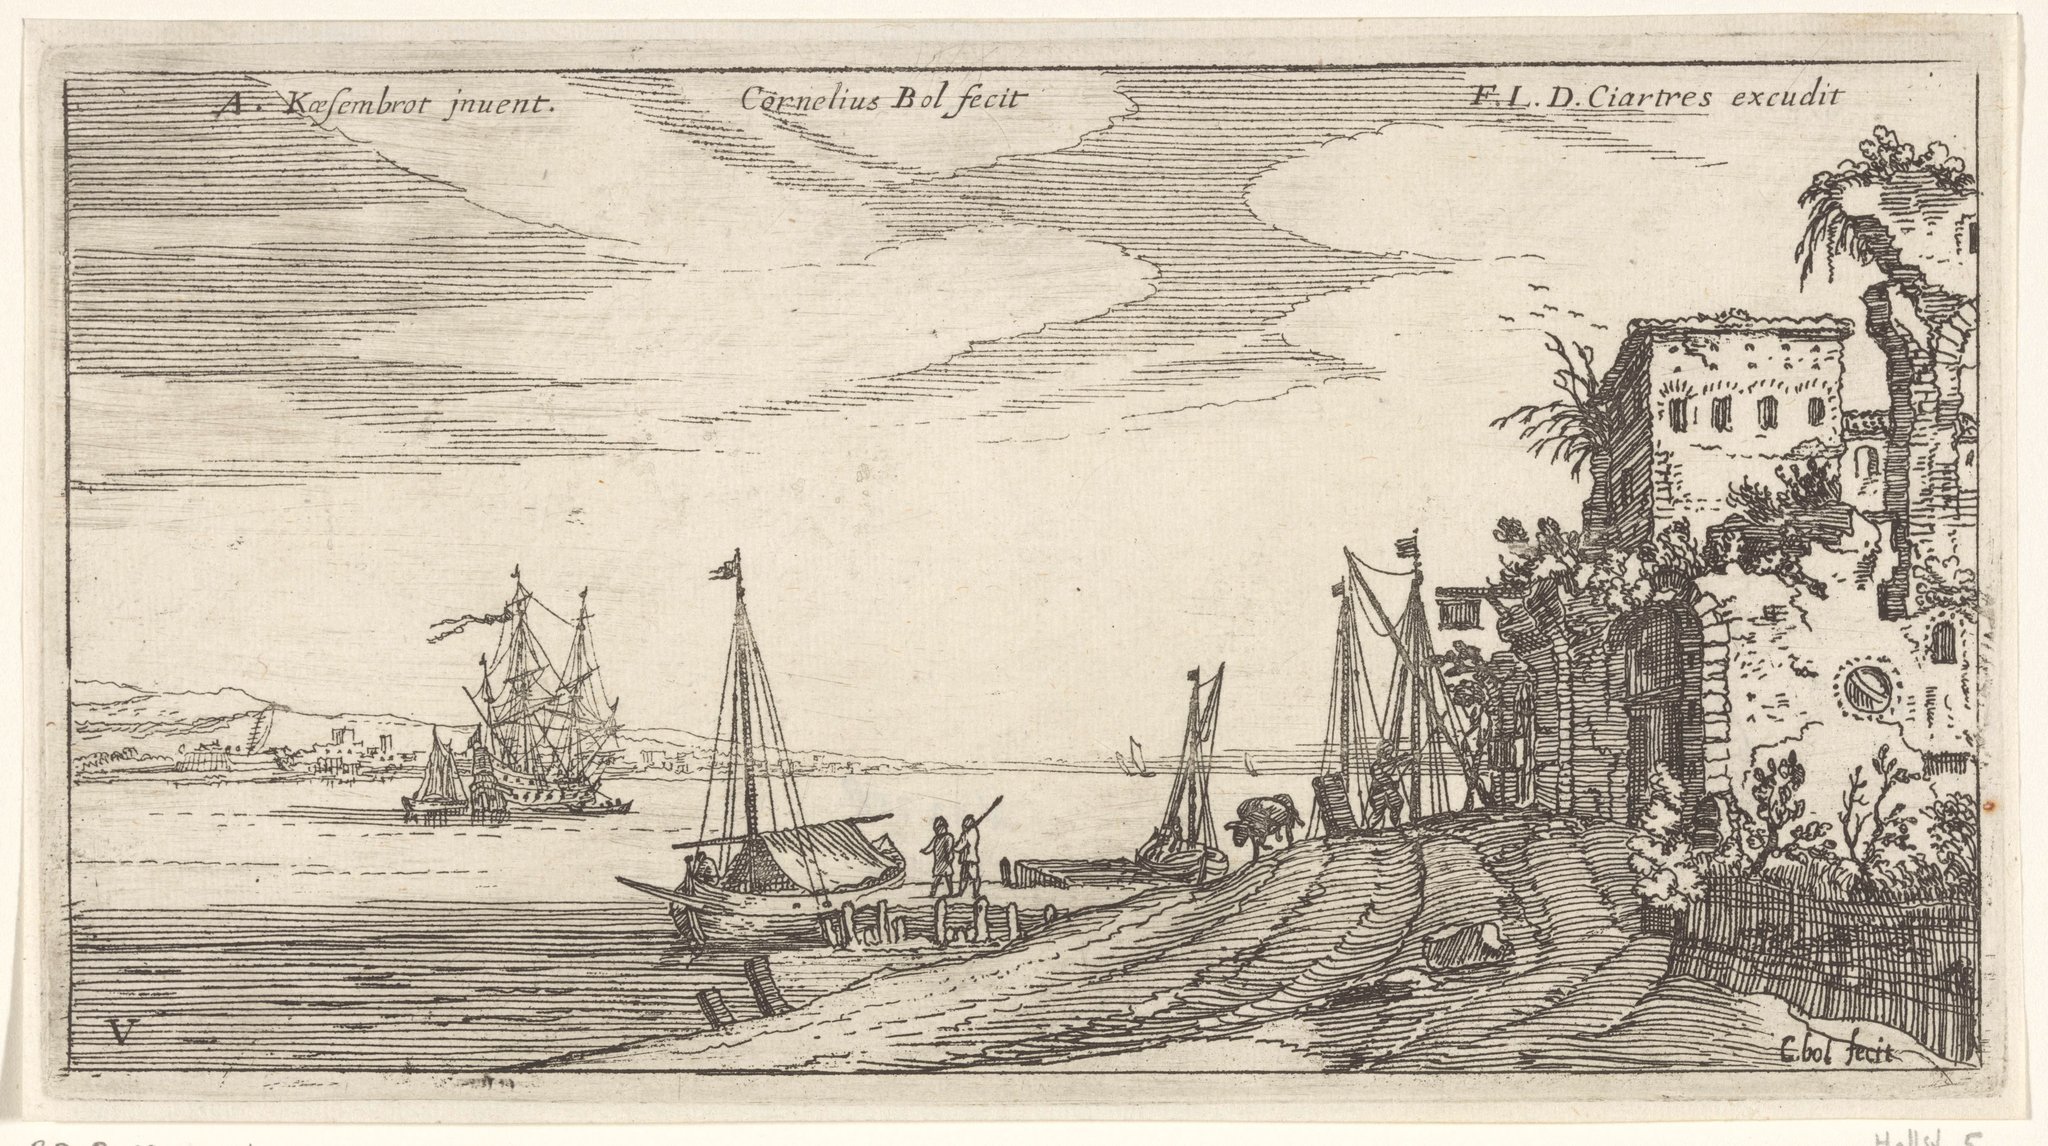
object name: print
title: Havengezichten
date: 1623-1666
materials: paper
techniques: etching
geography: paris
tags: harbour, inn, coffee-house, public house, etc.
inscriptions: collector's mark: Lugt 2228, collector's mark: Lugt 2542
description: Gezicht op een haven van een Italiaans kustplaats. Aan de kade staat een herberg. Prent uit een serie van vijf prenten met gezichten op Italiaanse havensteden.